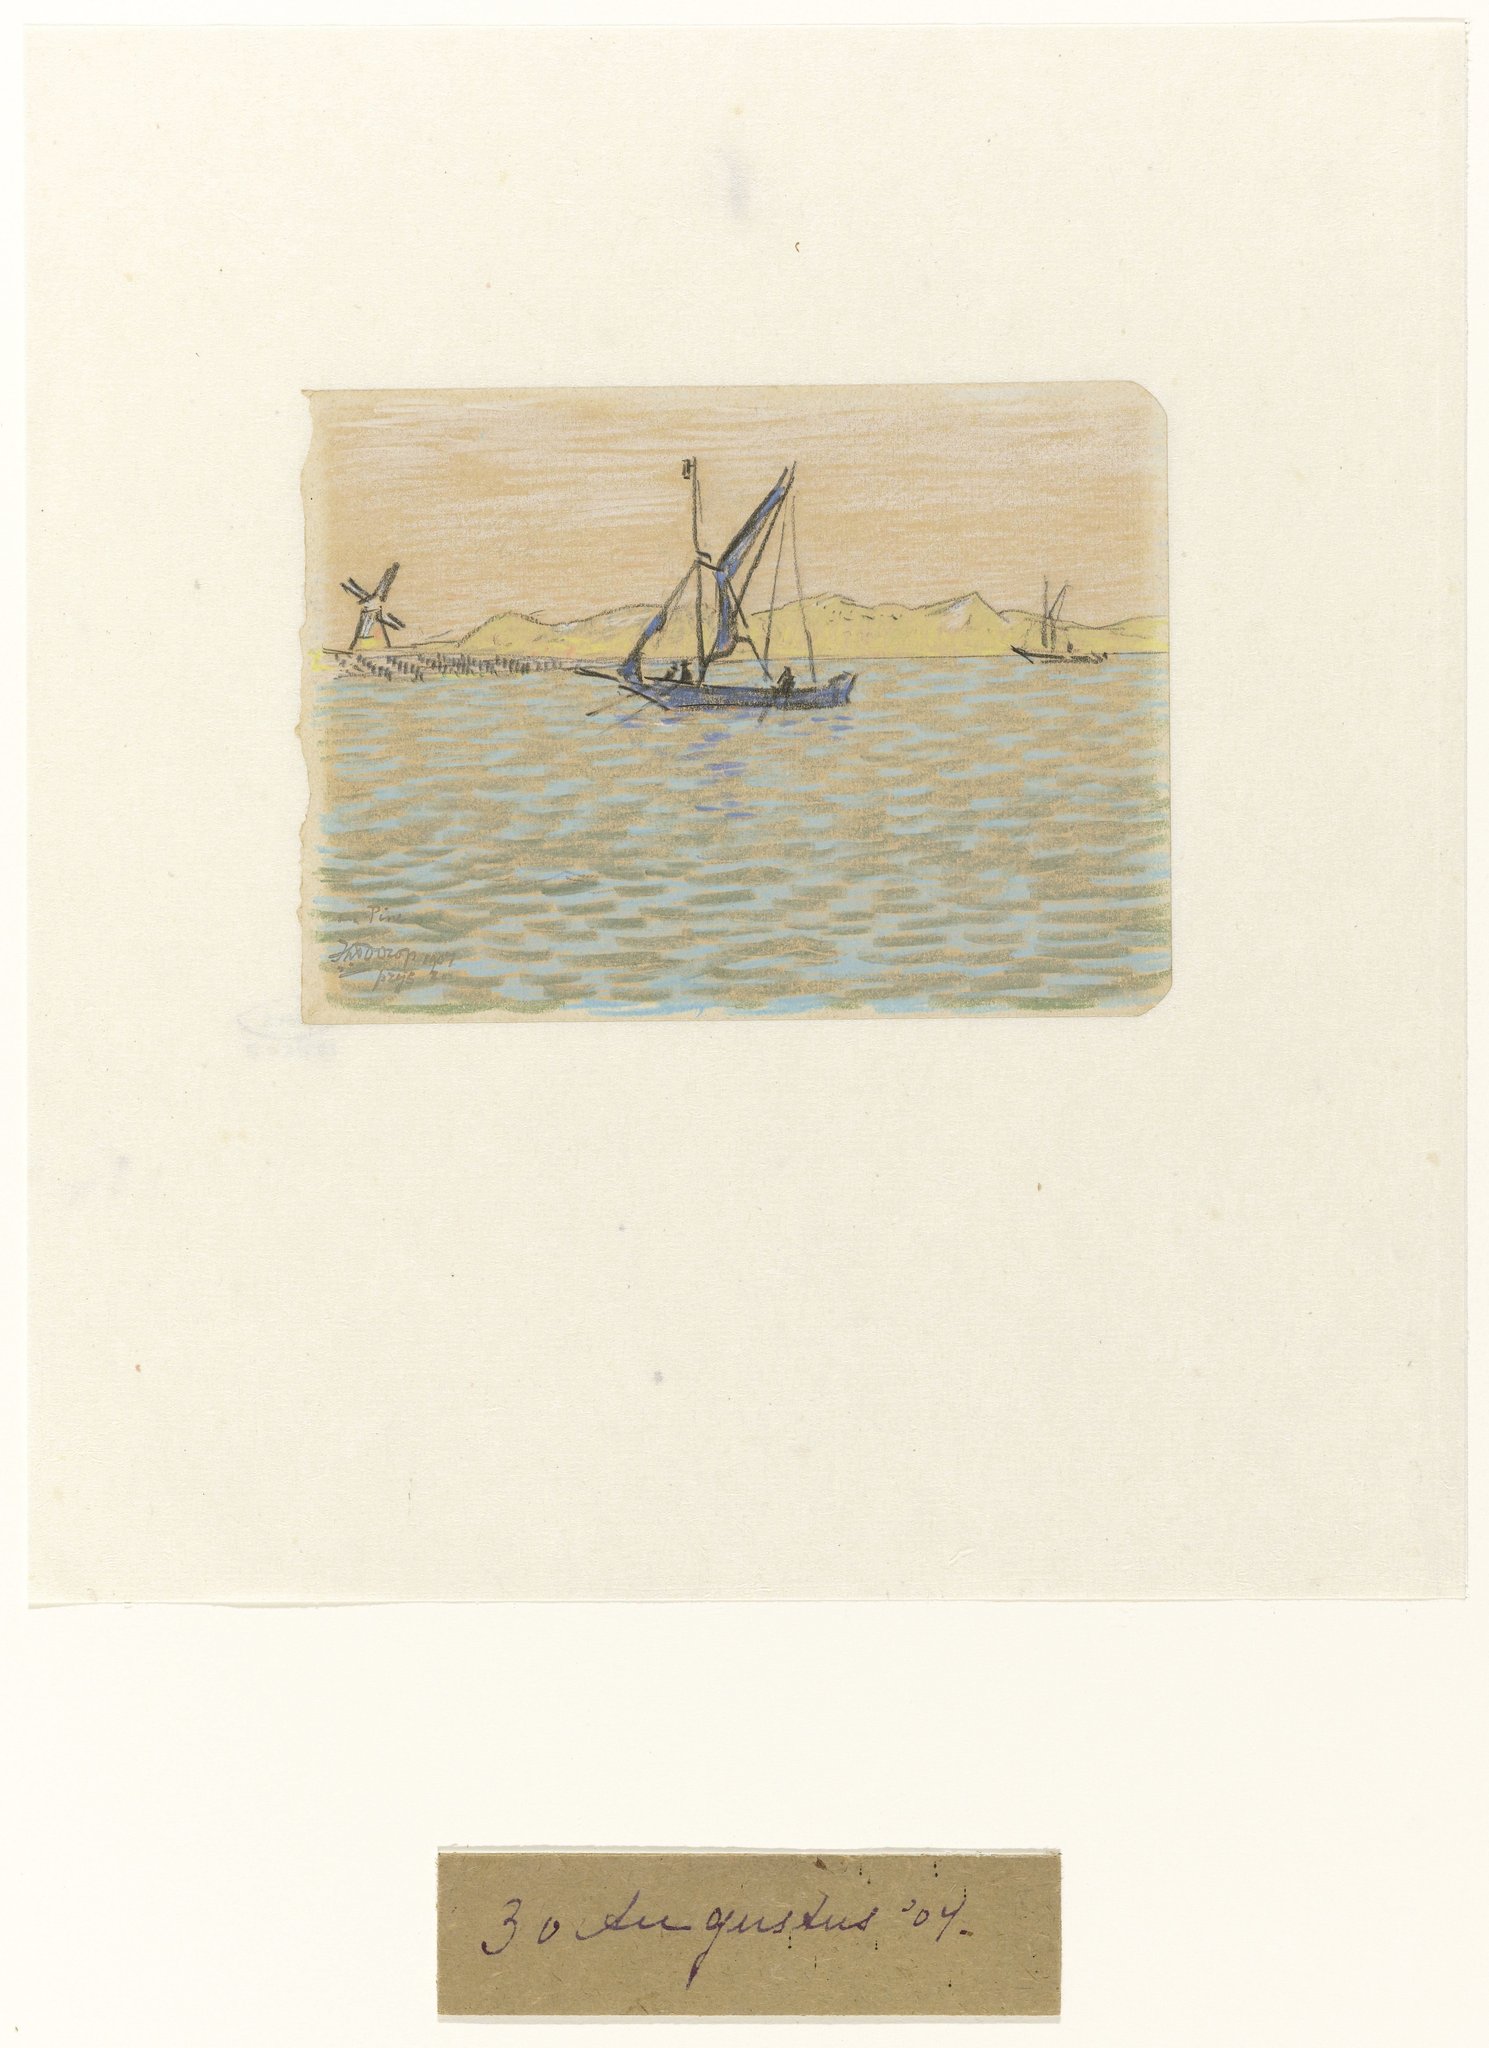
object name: drawing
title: Zeilboten voor de kust van Domburg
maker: jan toorop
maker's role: draughtsman, painter, print maker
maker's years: 1858-1928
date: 1907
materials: chalk, paper, pencil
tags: ships (in general), coast